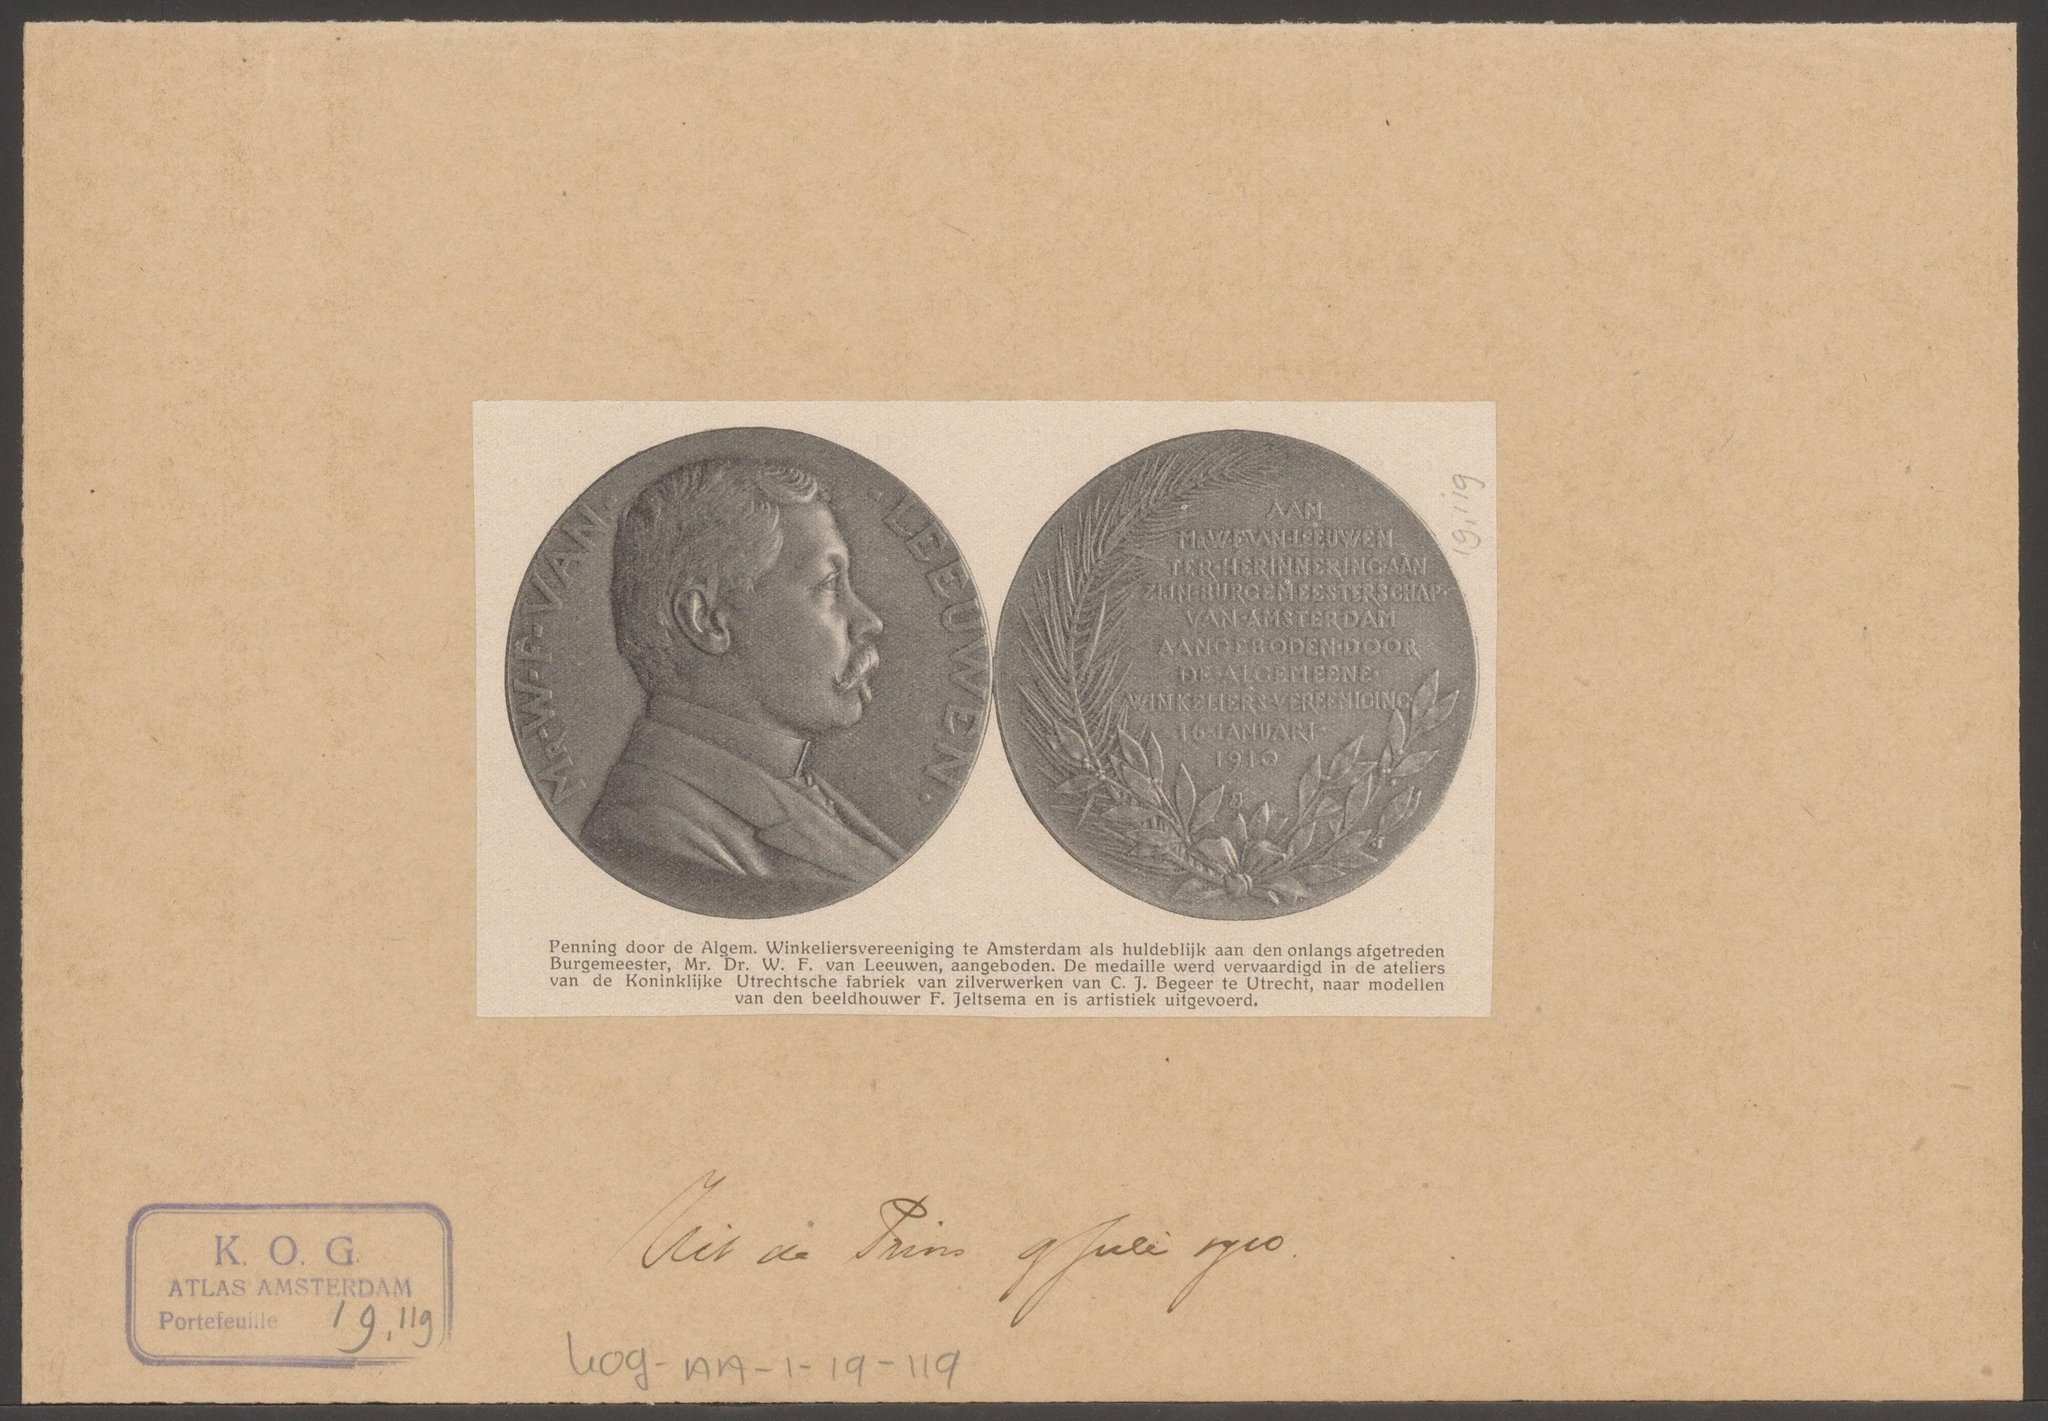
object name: photomechanical print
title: Voor- en achterzijde van een penning met het portret van Wilhelmus Frederik van Leeuwen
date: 1910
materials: paper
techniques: letterpress printing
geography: amsterdam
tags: surabaya, the hague, mayor, mayor, burgomaster, historical persons, amsterdam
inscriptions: collector's mark: ‘19,119’ Lugt 1641b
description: Onderwerpsrubriek binnen de Atlas Amsterdam: Herinneringen aan regeringsleden en hunne huisgezinnen [na 1800].